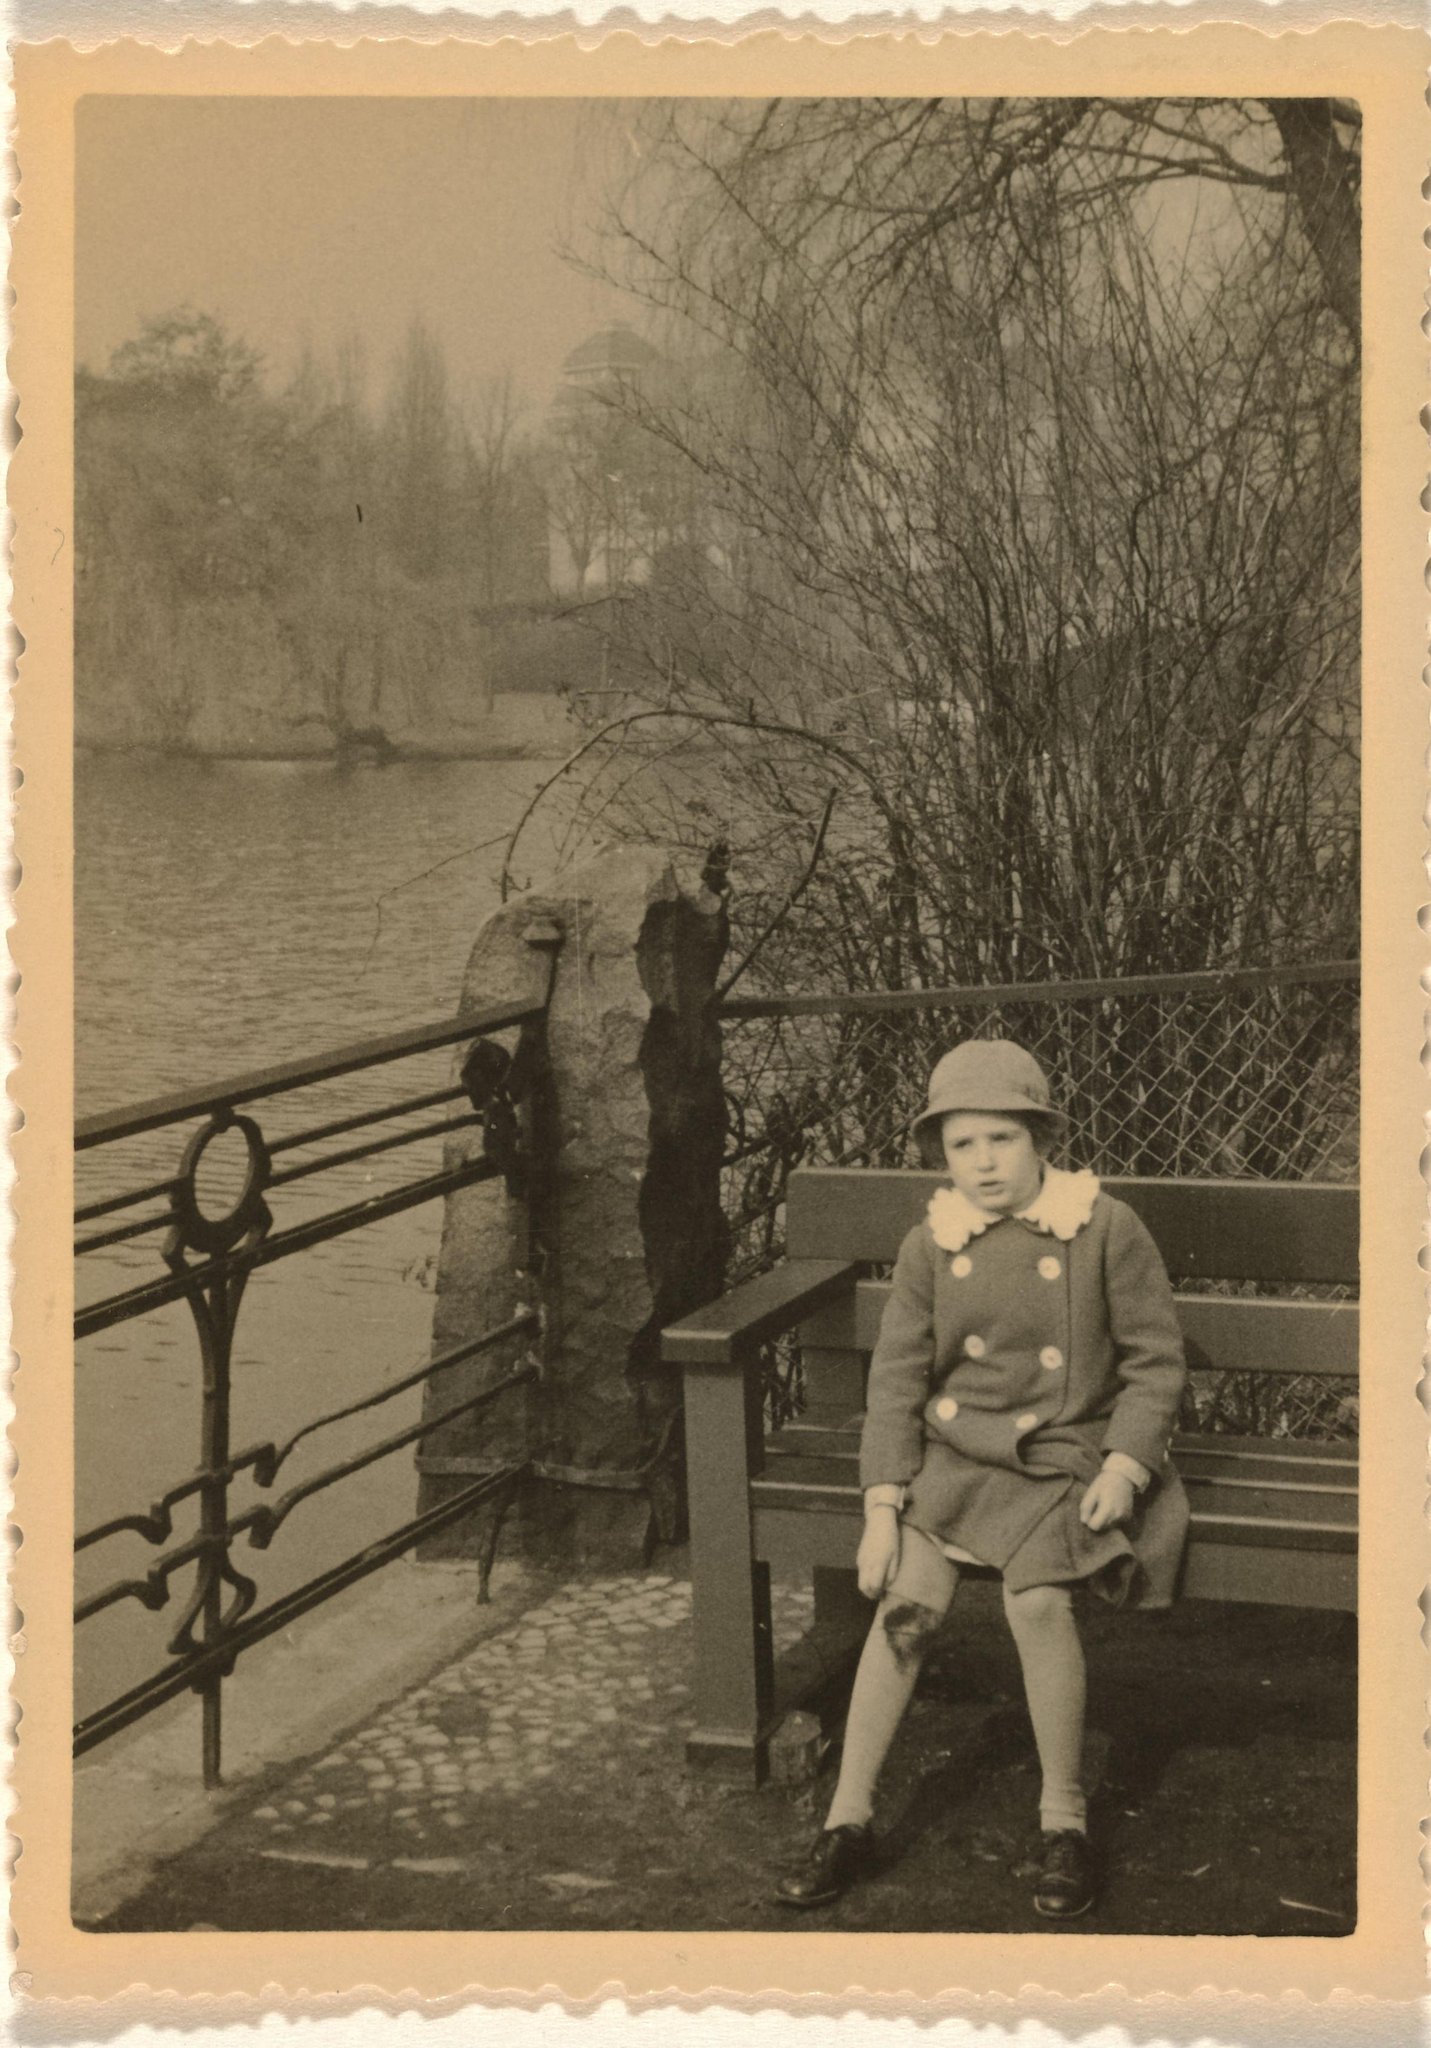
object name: photograph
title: Isabel Wachenheimer op een bankje aan de rivier de Alster in Hamburg, in 1935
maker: Anonymous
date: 1935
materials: photographic support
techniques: gelatin silver print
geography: hamburg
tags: isabel wachenheimer-elon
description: Dit object is onderdeel van de nalatenschap van Isabel Elon-Wachenheimer (1928-2010). Tot haar overlijden behoorde het samen met de andere objecten uit de nalatenschap tot haar privédomein van Isabel Wachenheimer. In die particuliere context zijn deze objecten tezamen en individueel aandenkens - aan de jeugd, ouders en familie van Isabel Wachenheimer vóór en tijdens de Shoah en aan haar leven na de Tweede Wereldoorlog. Isabel Wachenheimer, die van juni 1943 tot mei 1945 gevangen zat in Kamp Westerbork, Theresienstadt, Auschwitz, Lenzing a/d Oberdonau (een buitenkamp van Mauthausen), overleefde de Shoah. Haar ouders – Eugène Wachenheimer en Else Wachenheimer-Moos - werden op 14 oktober 1944 in Auschwitz-Birkenau vermoord.